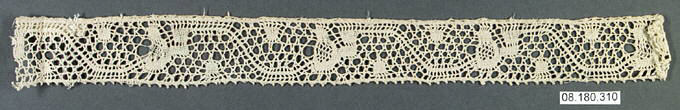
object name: fragment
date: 1801-1900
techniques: lace